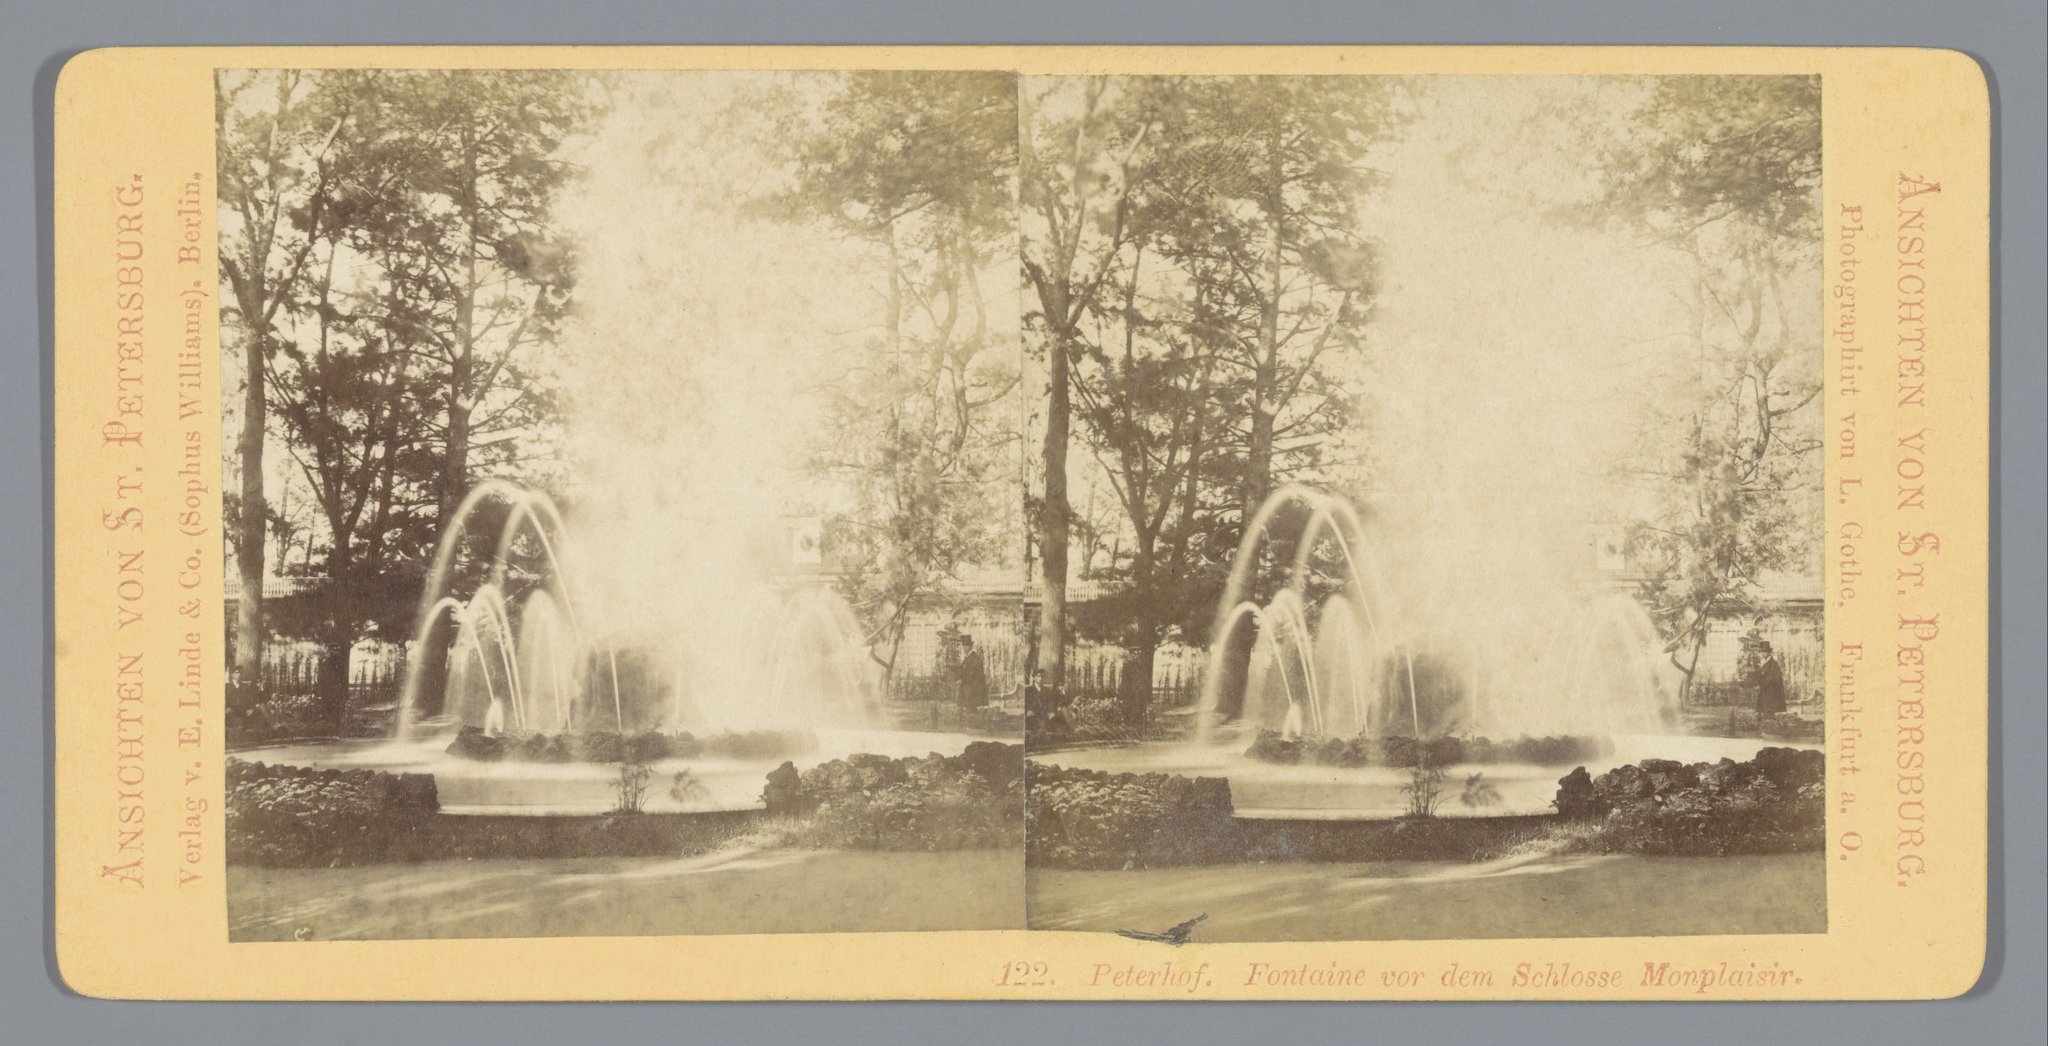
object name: stereograph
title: Fontein van het Paleis van Monplaisir in Peterhof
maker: louis gothe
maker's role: fotograaf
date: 1850-1880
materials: cardboard, photographic support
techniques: albumen print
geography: peterhof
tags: garden fountain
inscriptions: number: ‘122.’, inscription: ‘Ansichten von St. Petersburg.’